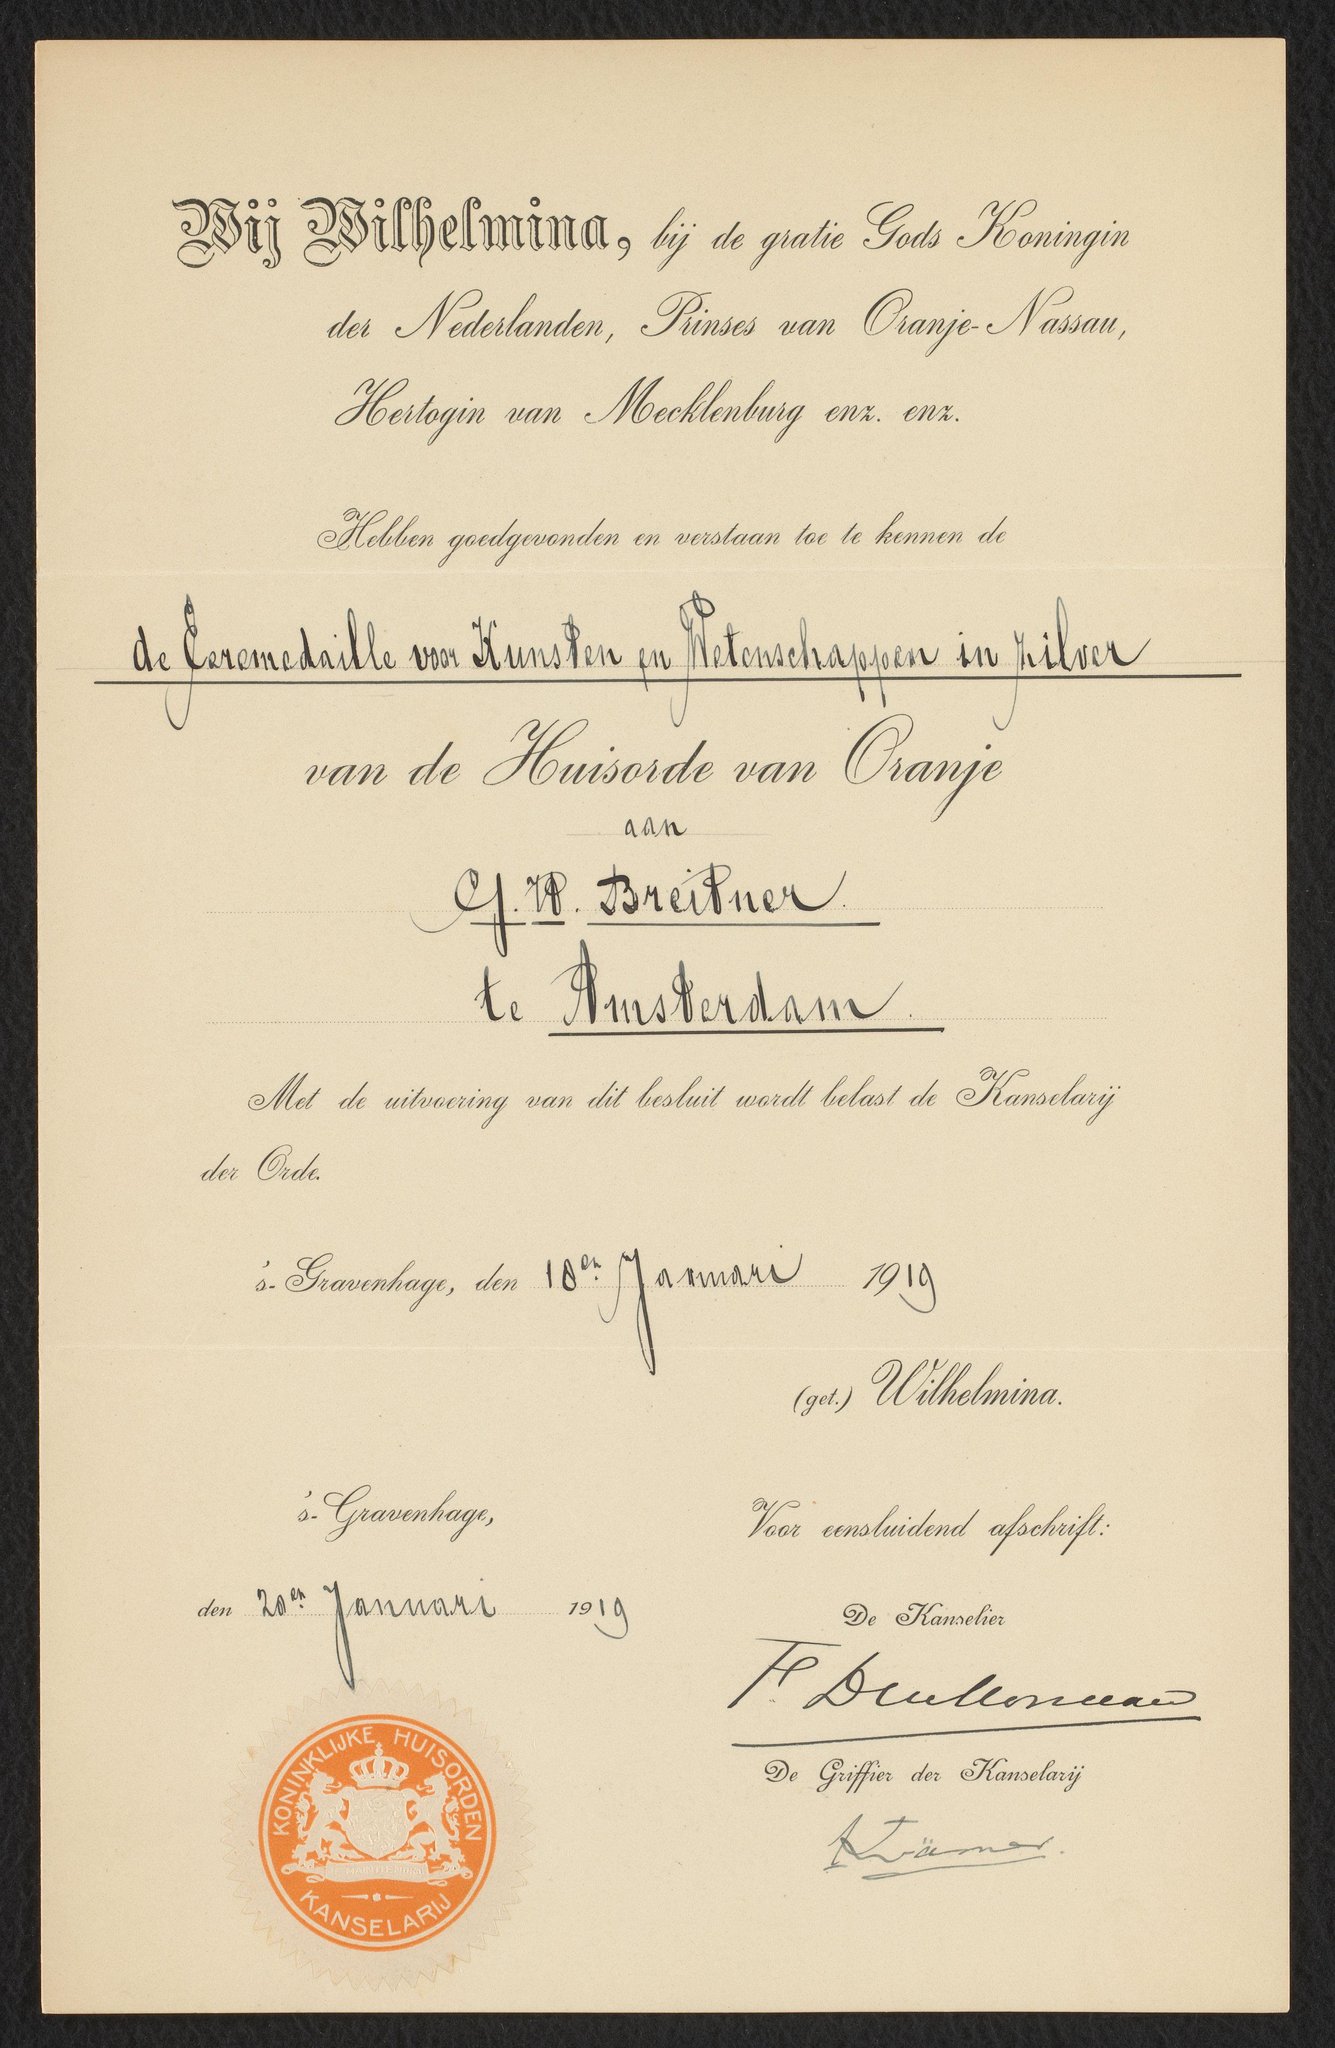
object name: charter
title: Oorkonde behorende bij de Eremedaille voor kunsten en wetenschappen in zilver van de Huisorde van Oranje, uitgereikt aan George Hendrik Breitner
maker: Anonymous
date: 1919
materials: ink, paper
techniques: blind stamped, letterpress printing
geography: the hague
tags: painter, print maker, draughtsman, george hendrik breitner, distribution of awards ~ art contest